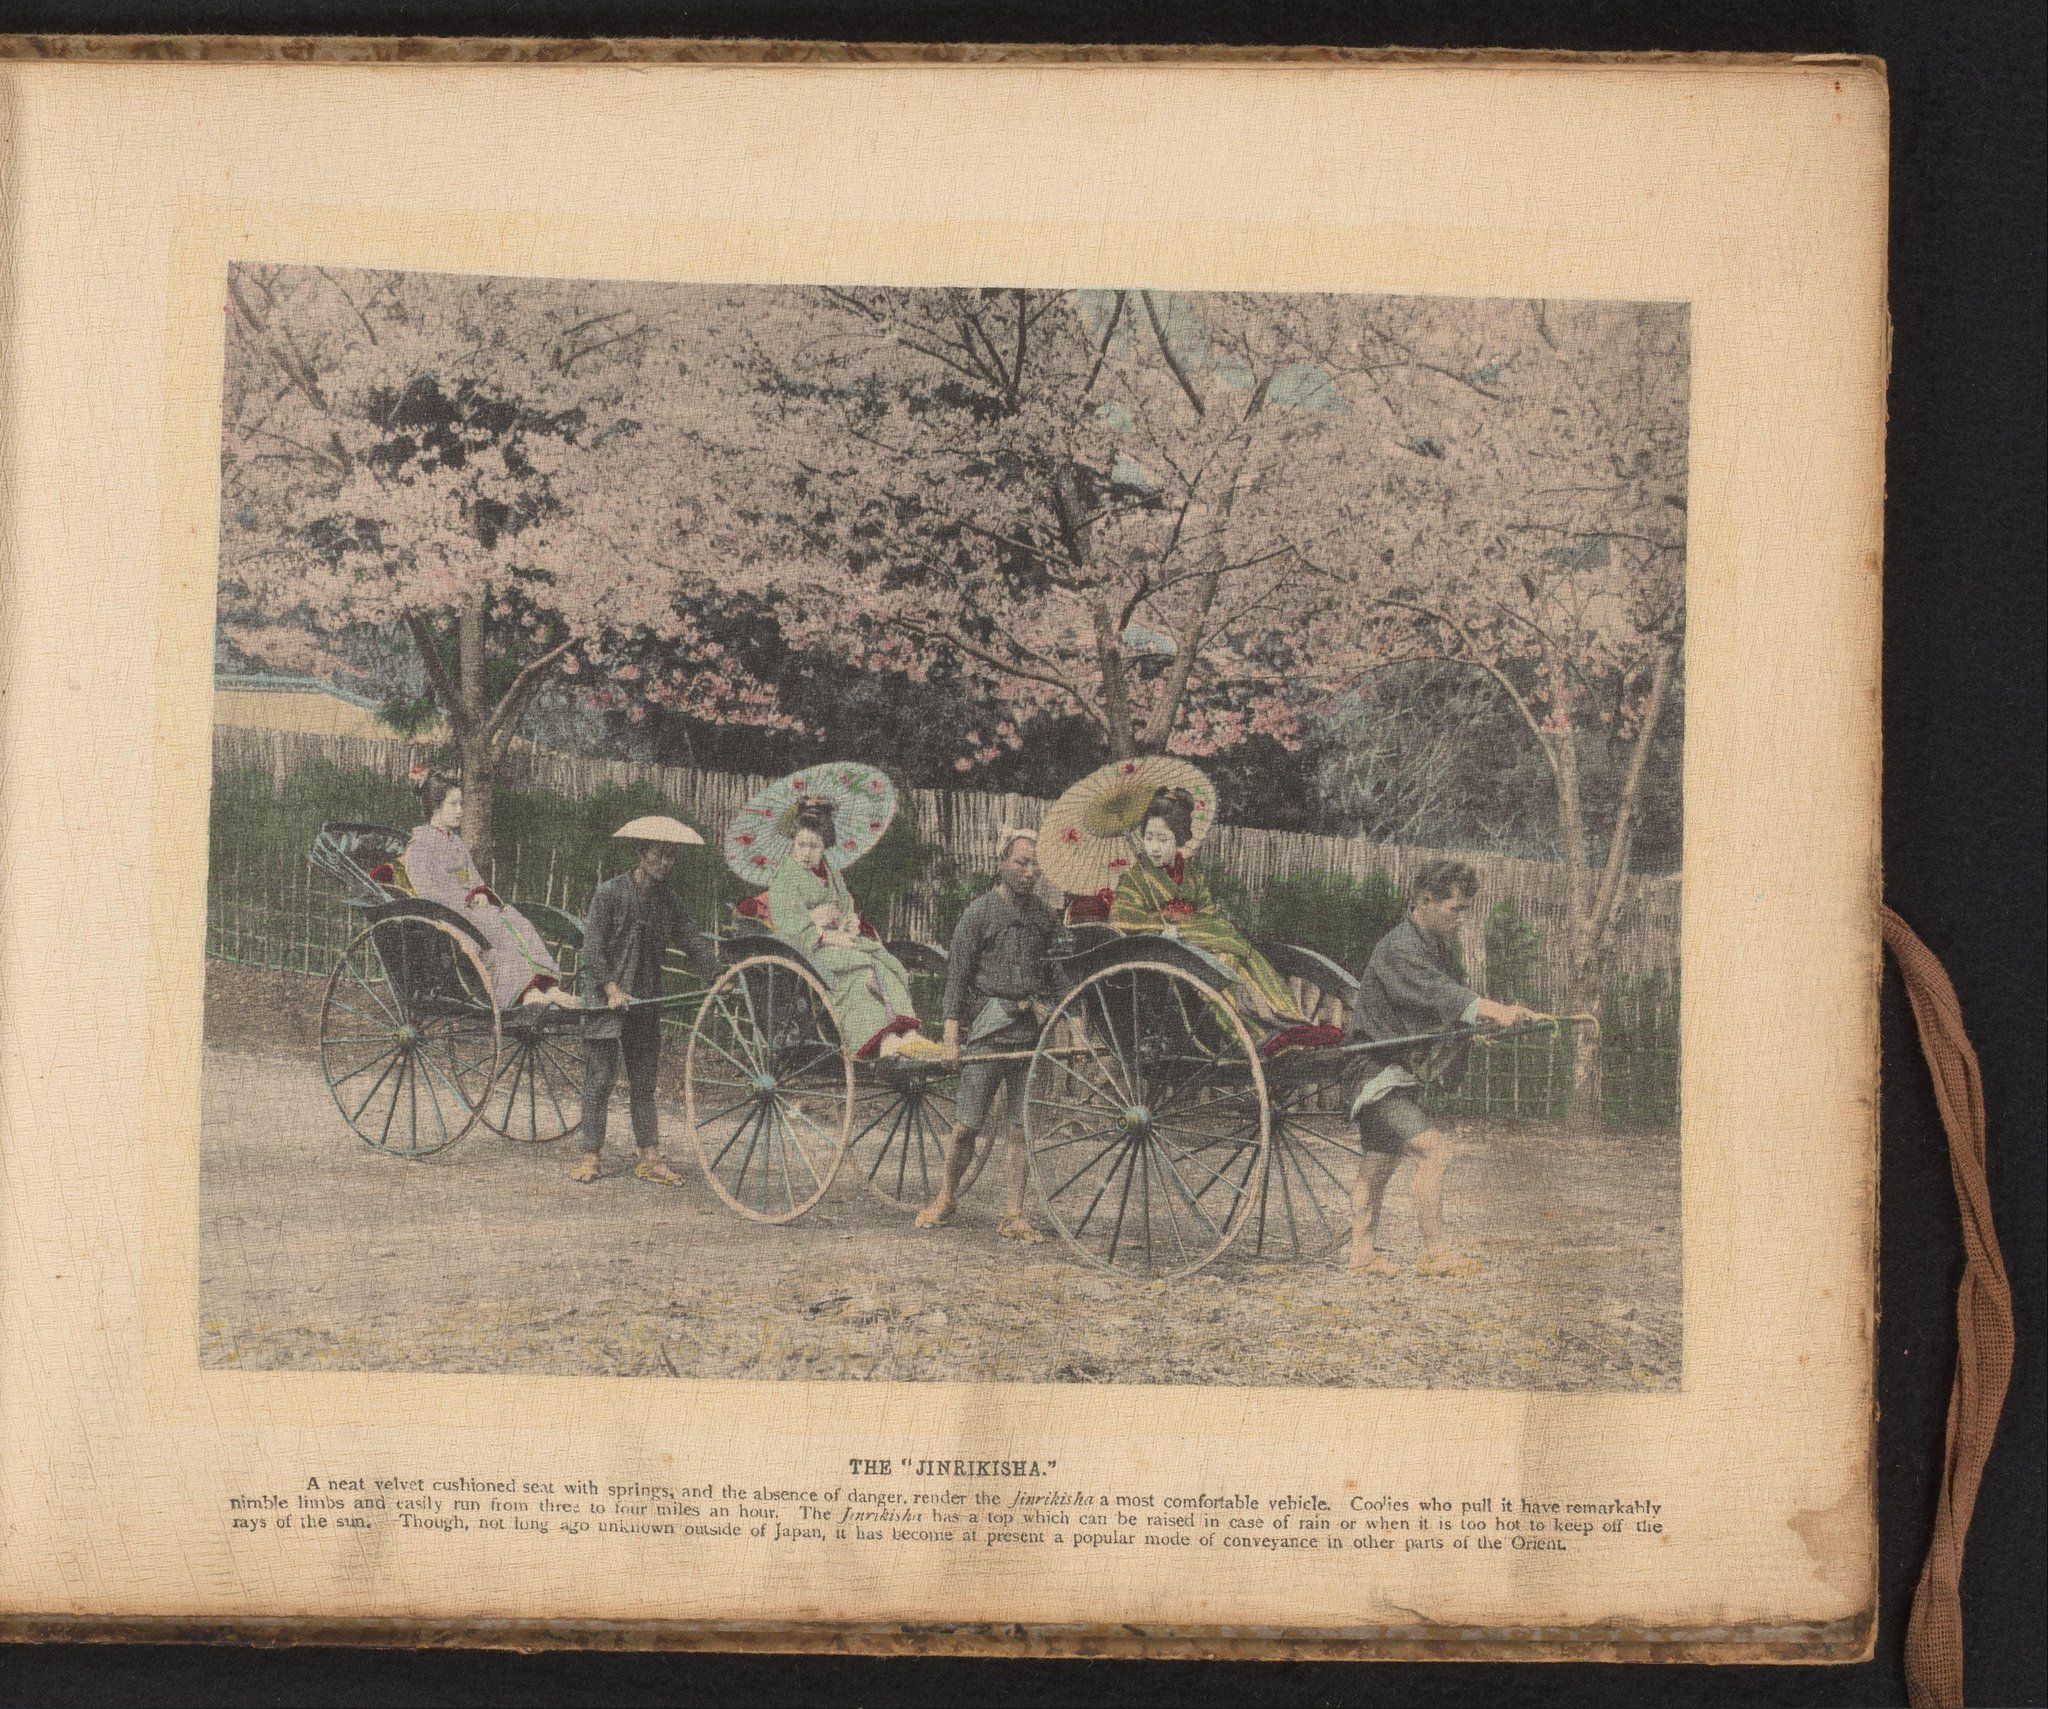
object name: photomechanical print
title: Drie onbekende vrouwen op riksja's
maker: Anonymous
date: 1891-1896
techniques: collotype process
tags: rickshaw, japan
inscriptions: inscription: ‘A neat velvet cushioned seat with spings, and the absence of danger, render the Jinrikisha a most comfortable vehicle. [...]’